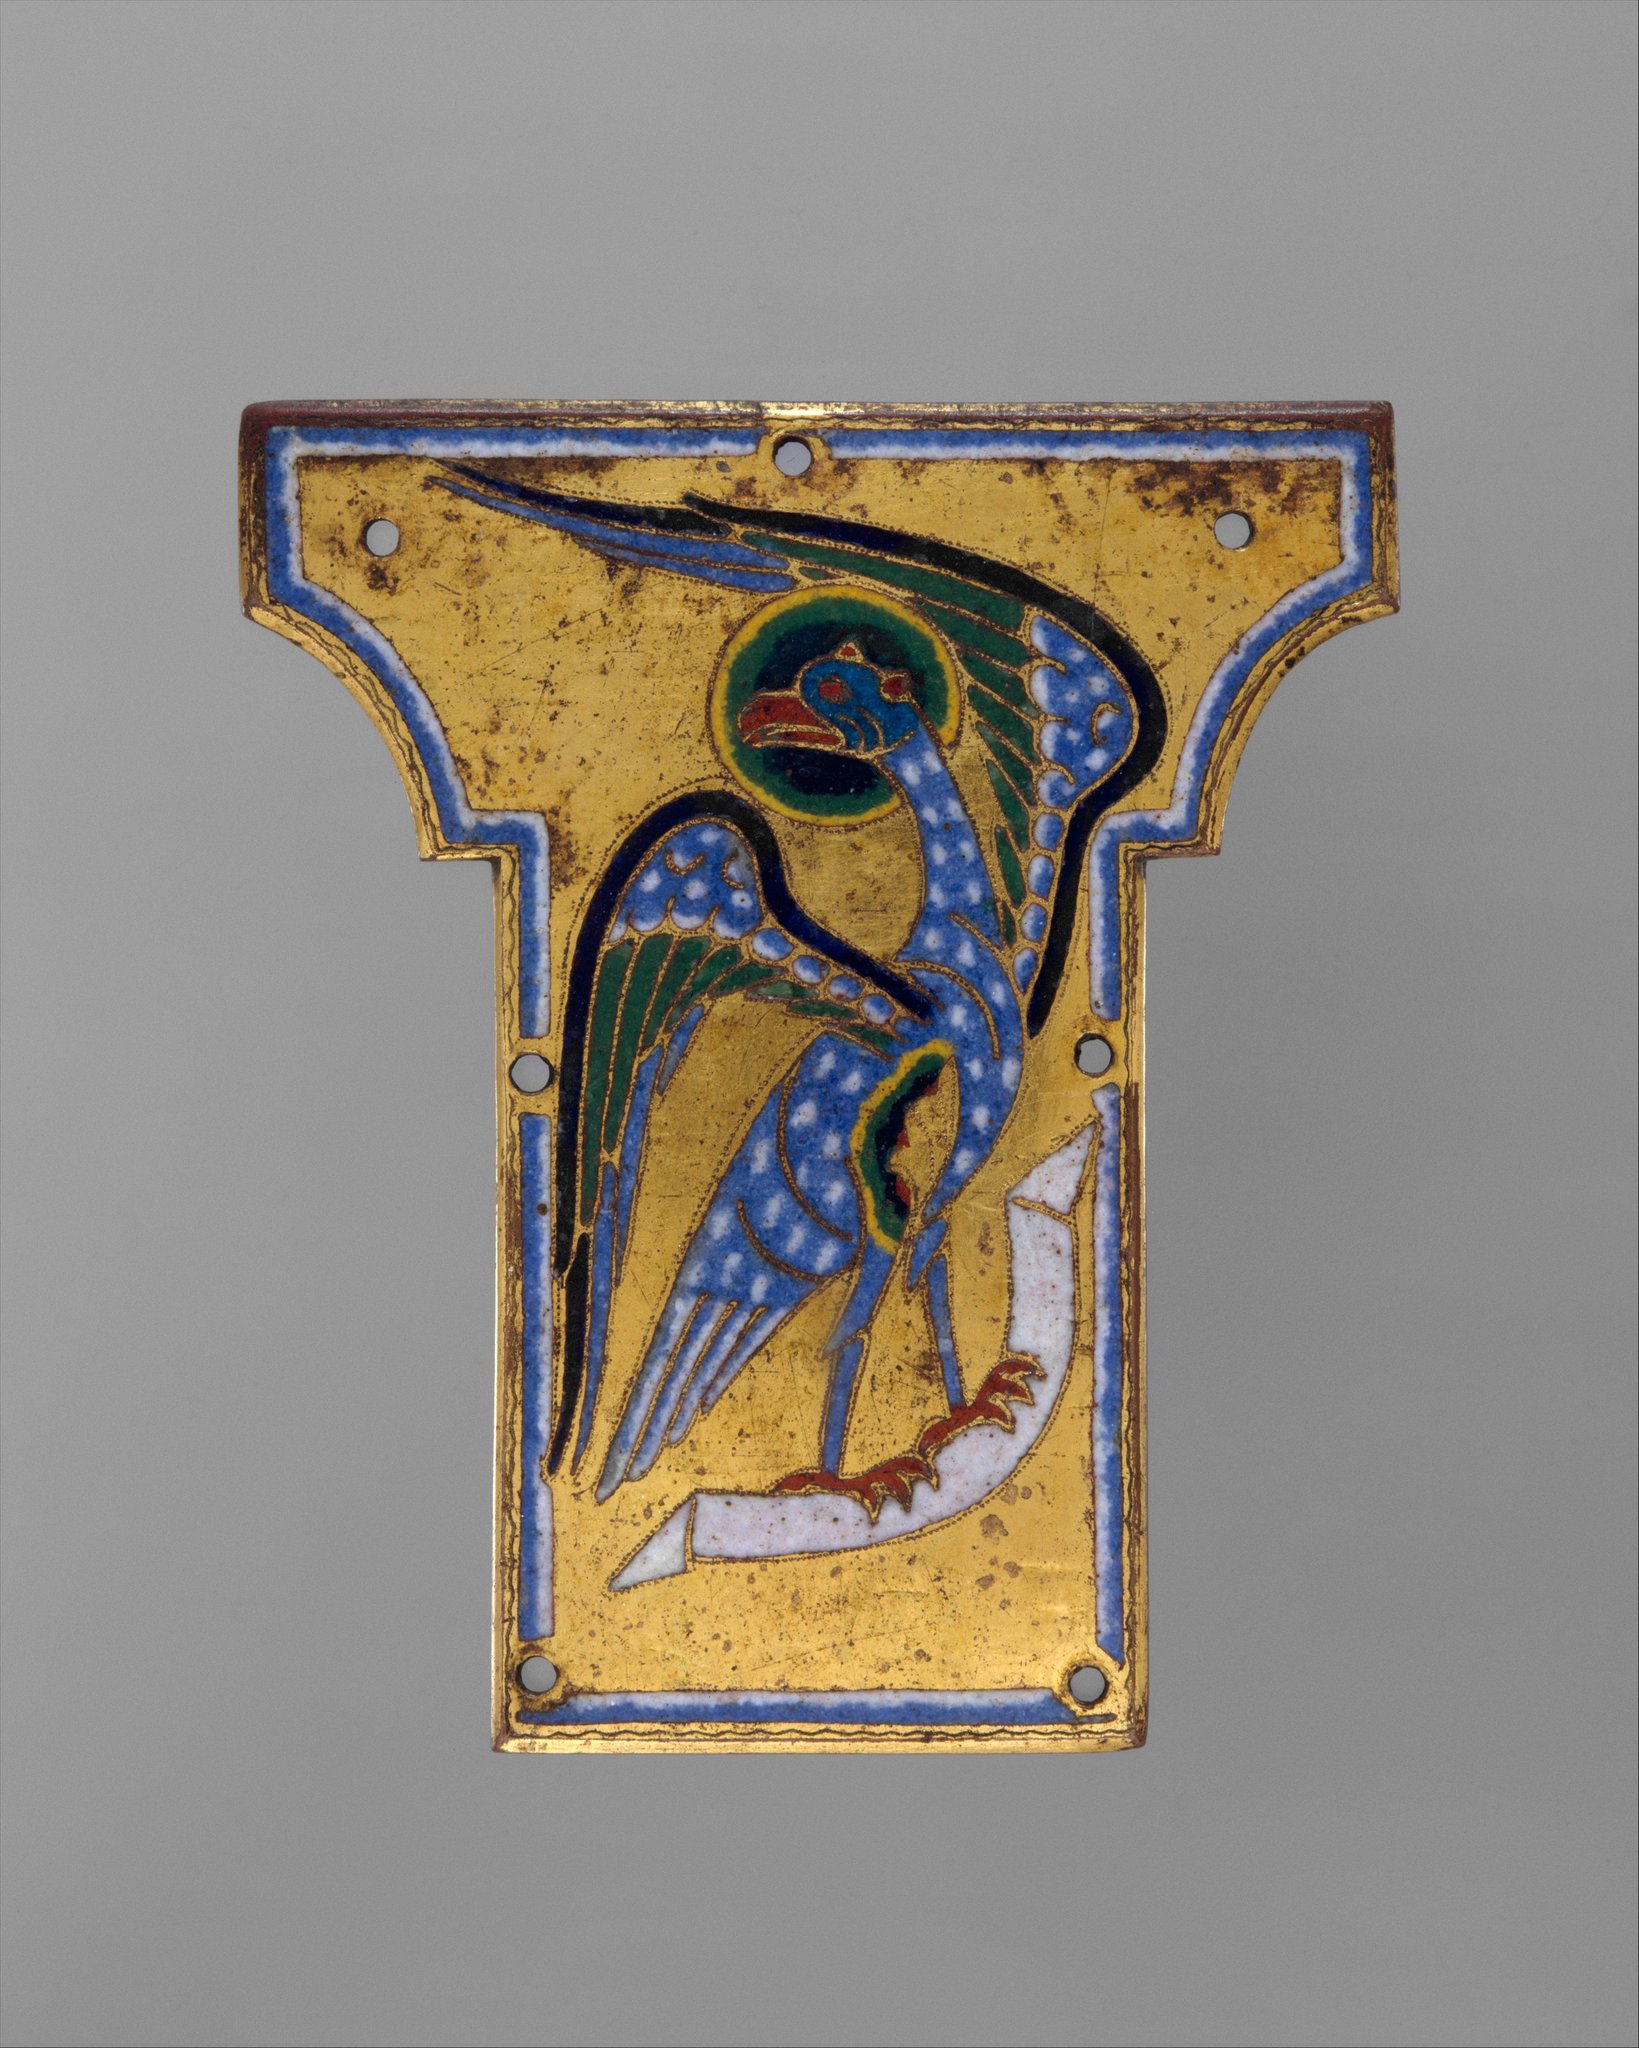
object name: plaque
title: Plaque from a Cross with the Eagle of Saint John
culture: french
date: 1185-1195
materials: copper, enamel, gilt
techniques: enamel, engraving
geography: france